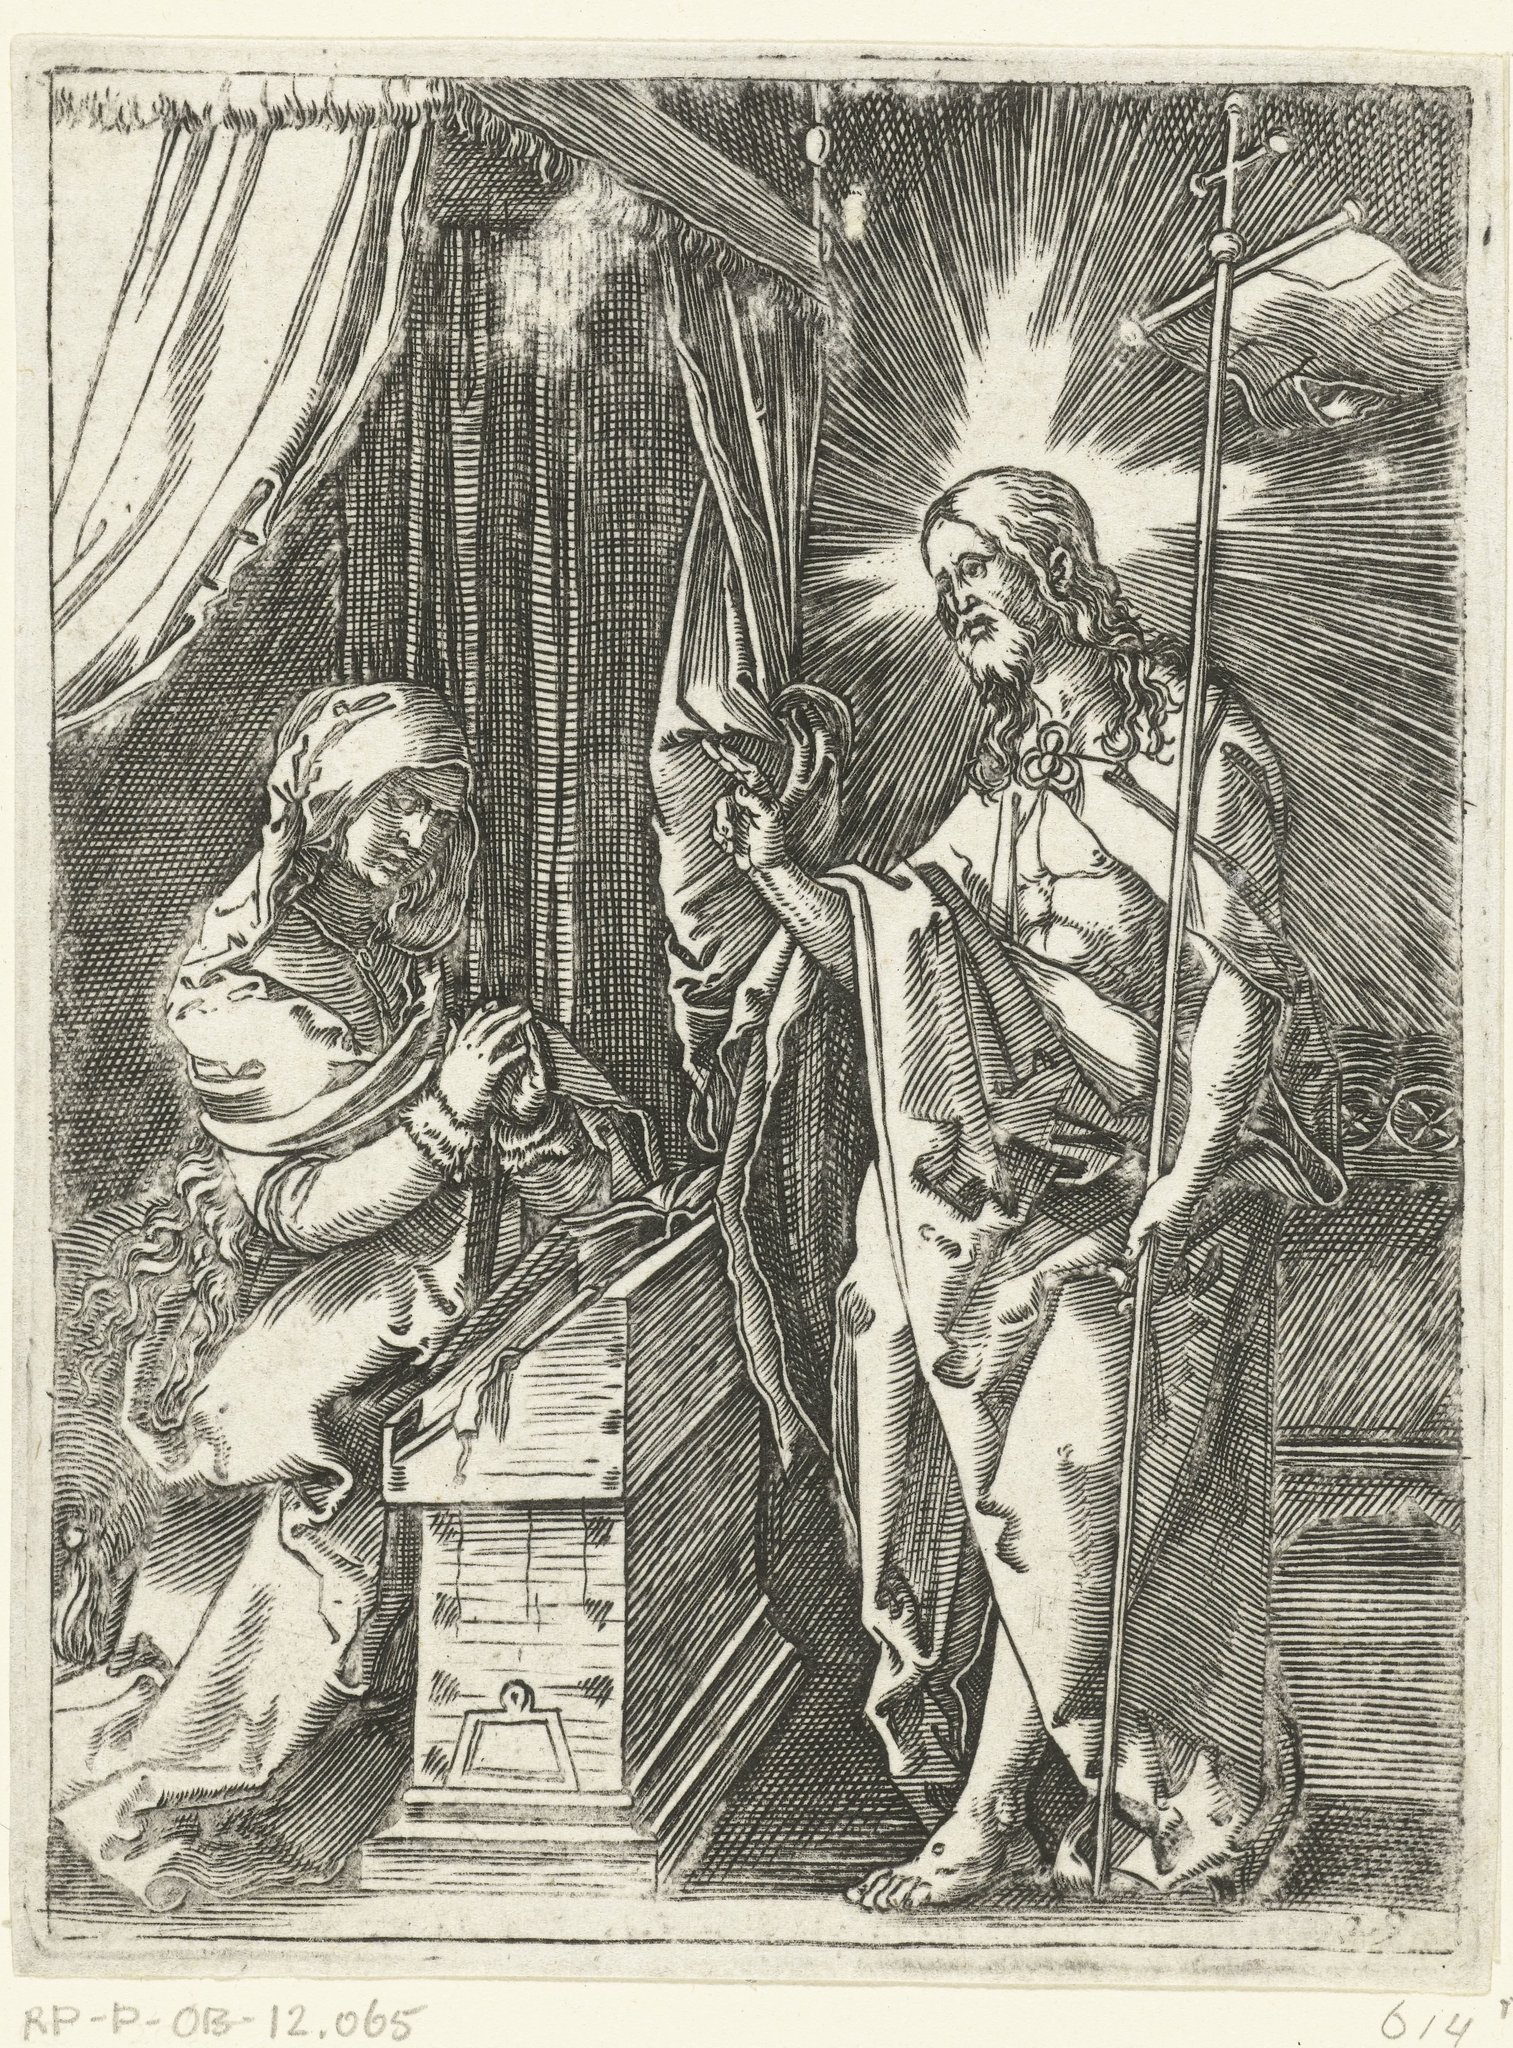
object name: print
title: Christus verschijnt aan Maria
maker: marcantonio raimondi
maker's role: print maker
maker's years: 1470-1534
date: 1510-1515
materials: paper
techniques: engraving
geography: italy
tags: christ, perhaps dressed as a pilgrim, appearing to his mother, who is usually shown praying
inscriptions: collector's mark: Lugt 12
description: Prent naar houtsnede van Albrecht Dürer uit een serie van zevenendertig prenten met als onderwerp het levensverhaal van Christus, bekend als Passie van Christus.